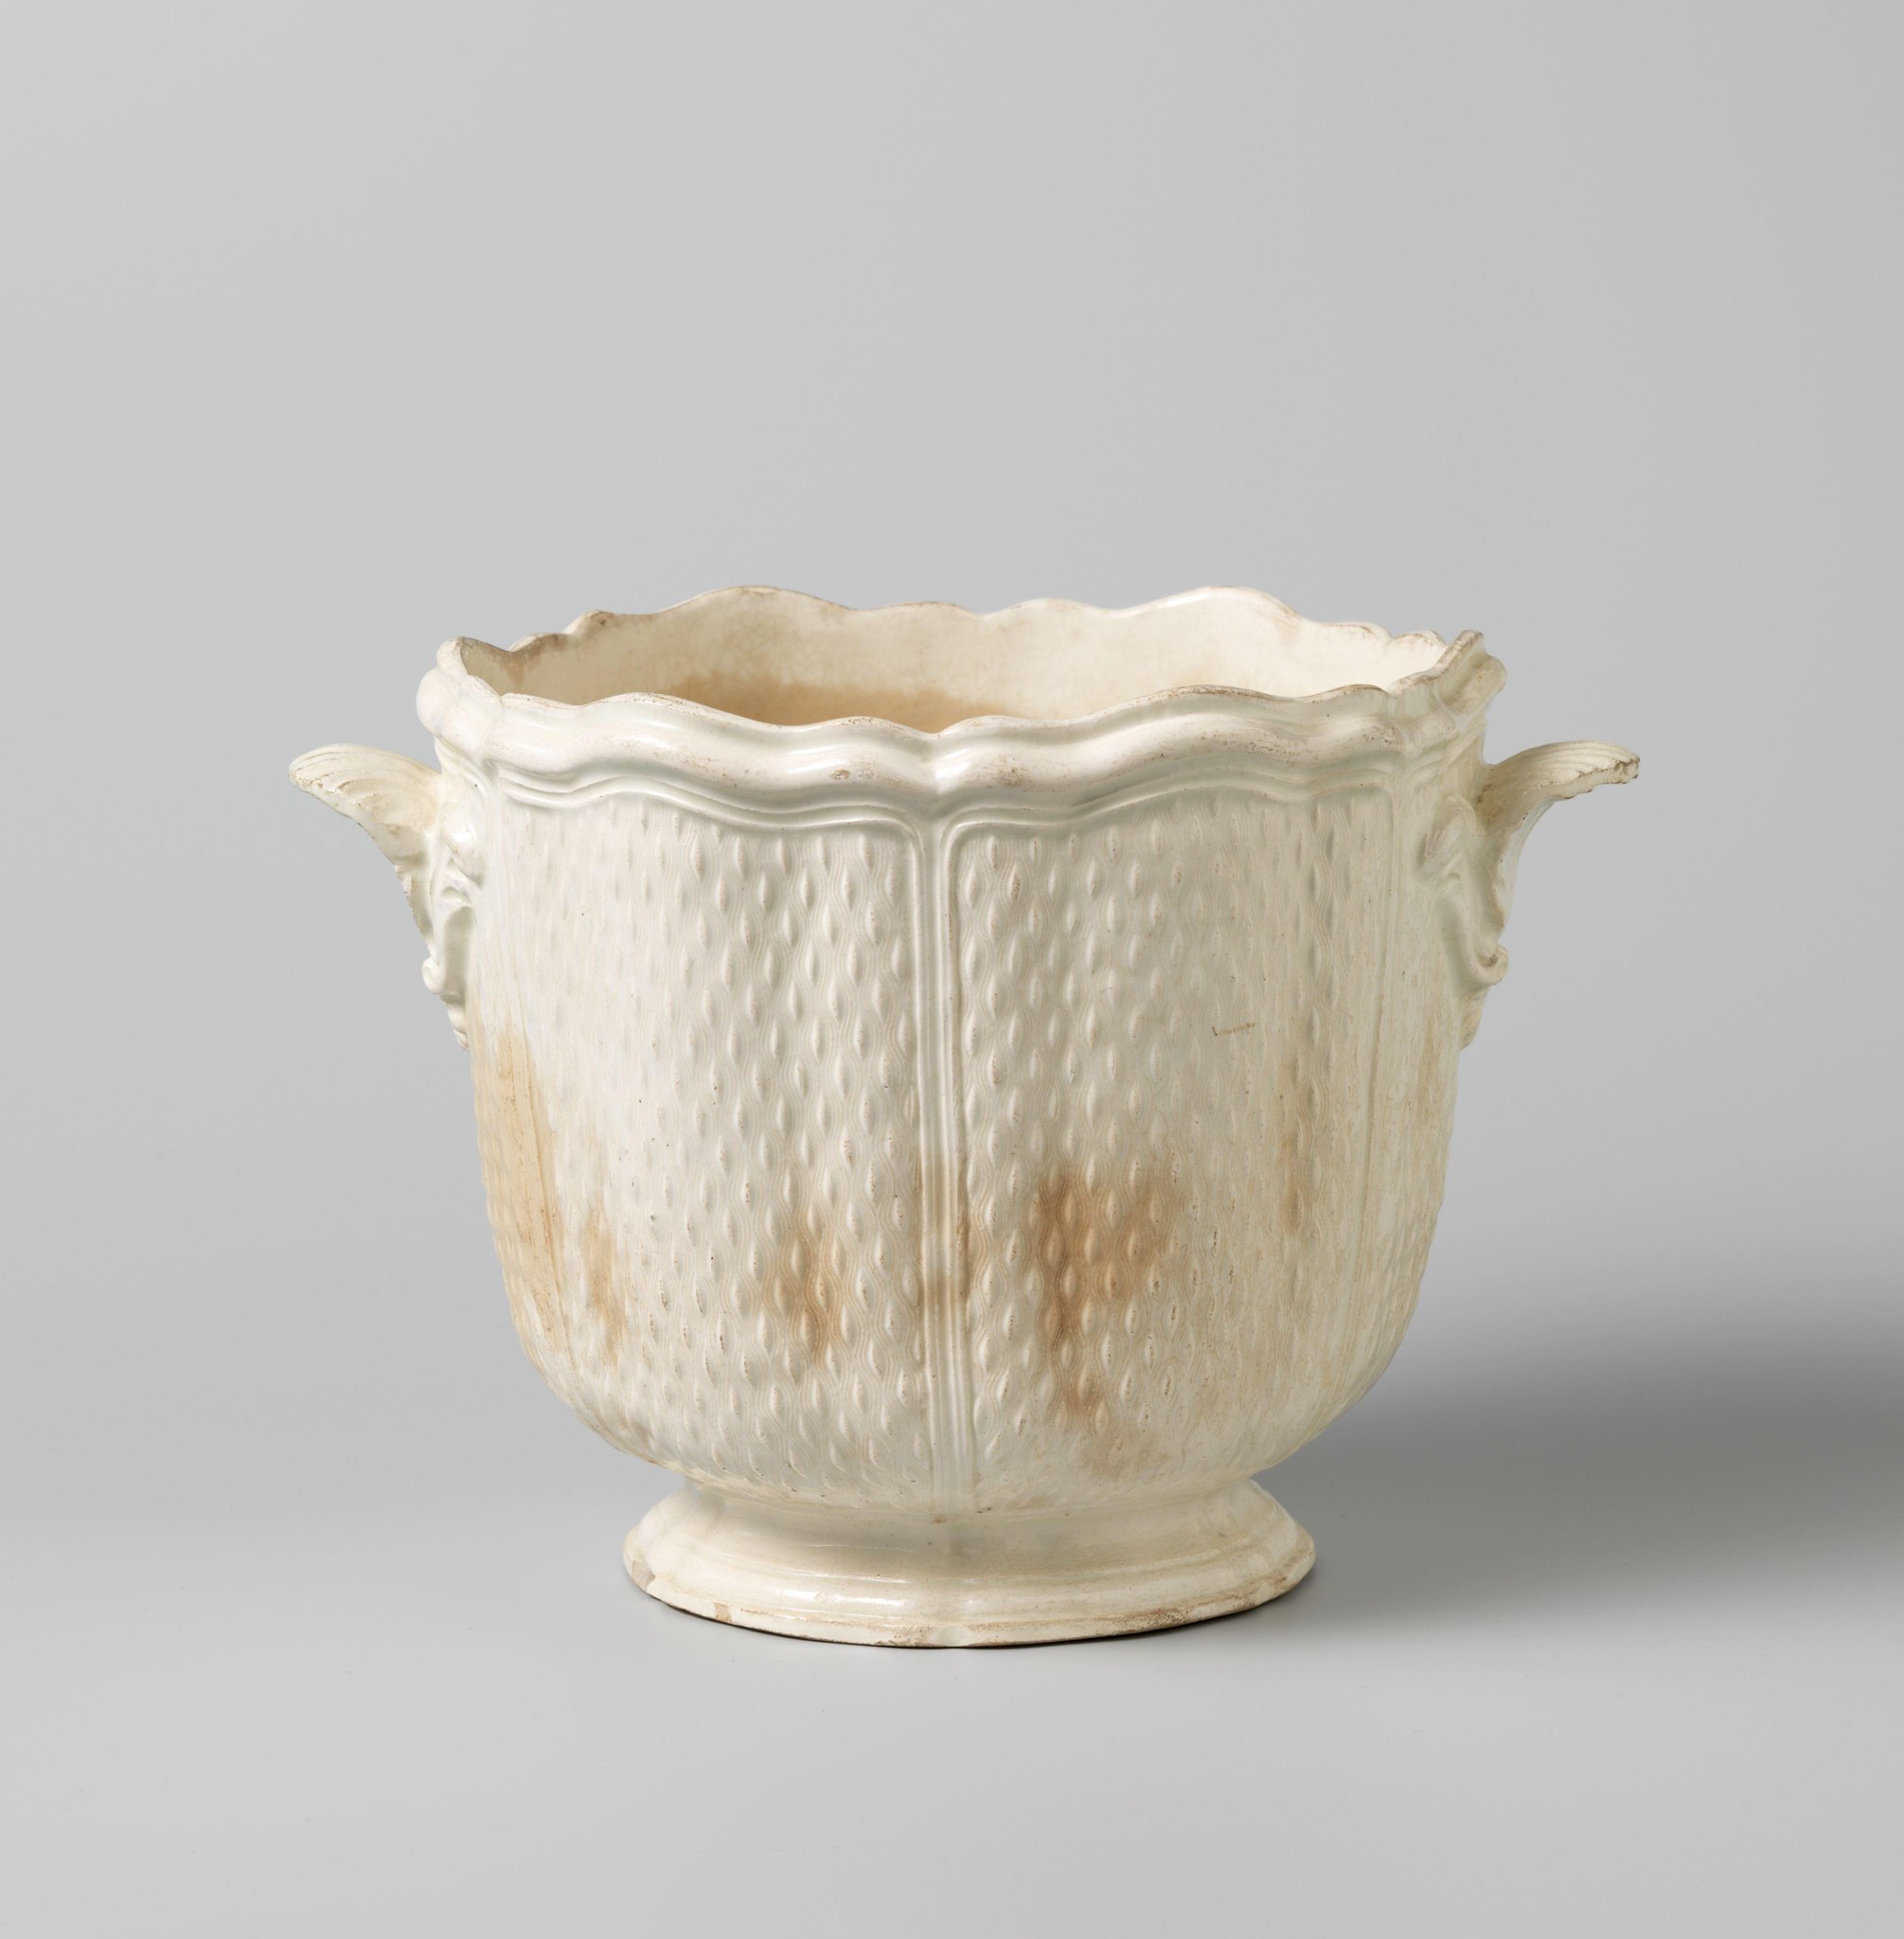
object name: wine cooler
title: Halfbolvormige koelvat van Engels hardgebakken aardewerk, faience fine van Pont-aux-Choux.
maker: Anonymous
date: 1760-1780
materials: earthenware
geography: france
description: Halfbolvormig koelvat van hardgebakken aardewerk. Het vat staat op een geprofileerde voet en heeft twee schelpvormige handvatten. De gegolfde buitenzijde wordt door eenvoudige lijstversiering verdeeld in zes gelijke vakken met een grond van strepen en stippen in reliëf. De bovenrand is gegolfd. Bij het koelvat hoort een tweede koelvat met invnr. BK-NM-12216-B.